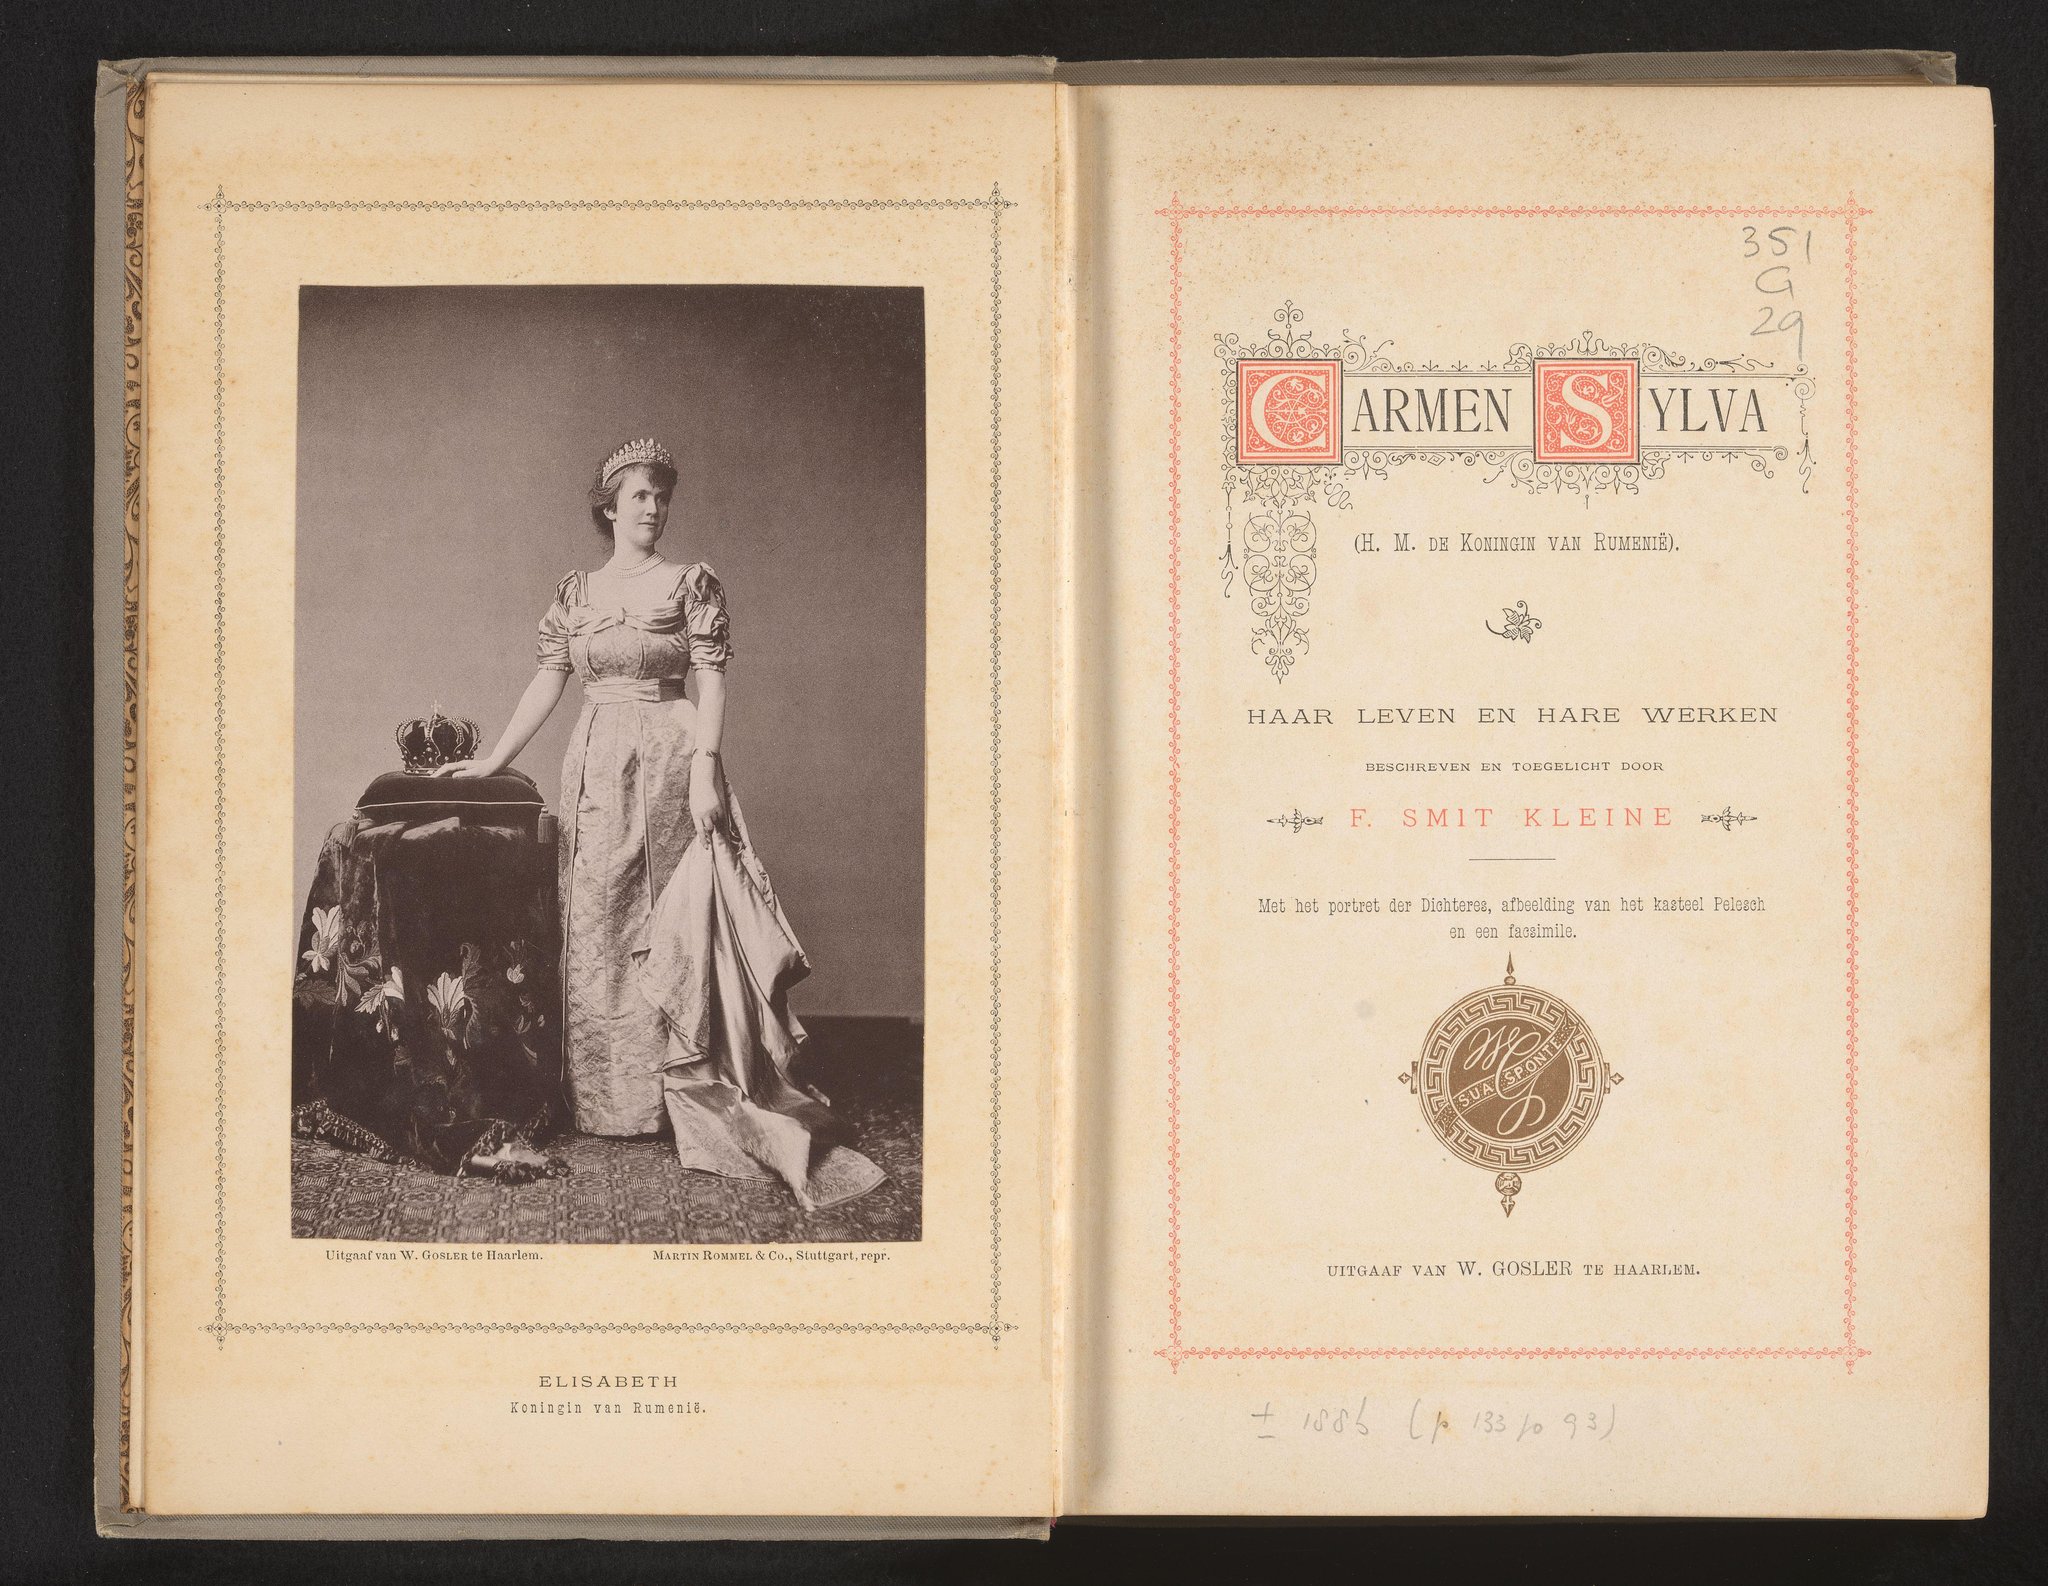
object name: photomechanical print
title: Portret van Elisabeth zu Wied, koningin van Roemenië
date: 1881-1886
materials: paper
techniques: photograph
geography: stuttgart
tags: historical persons - bb - woman, queen